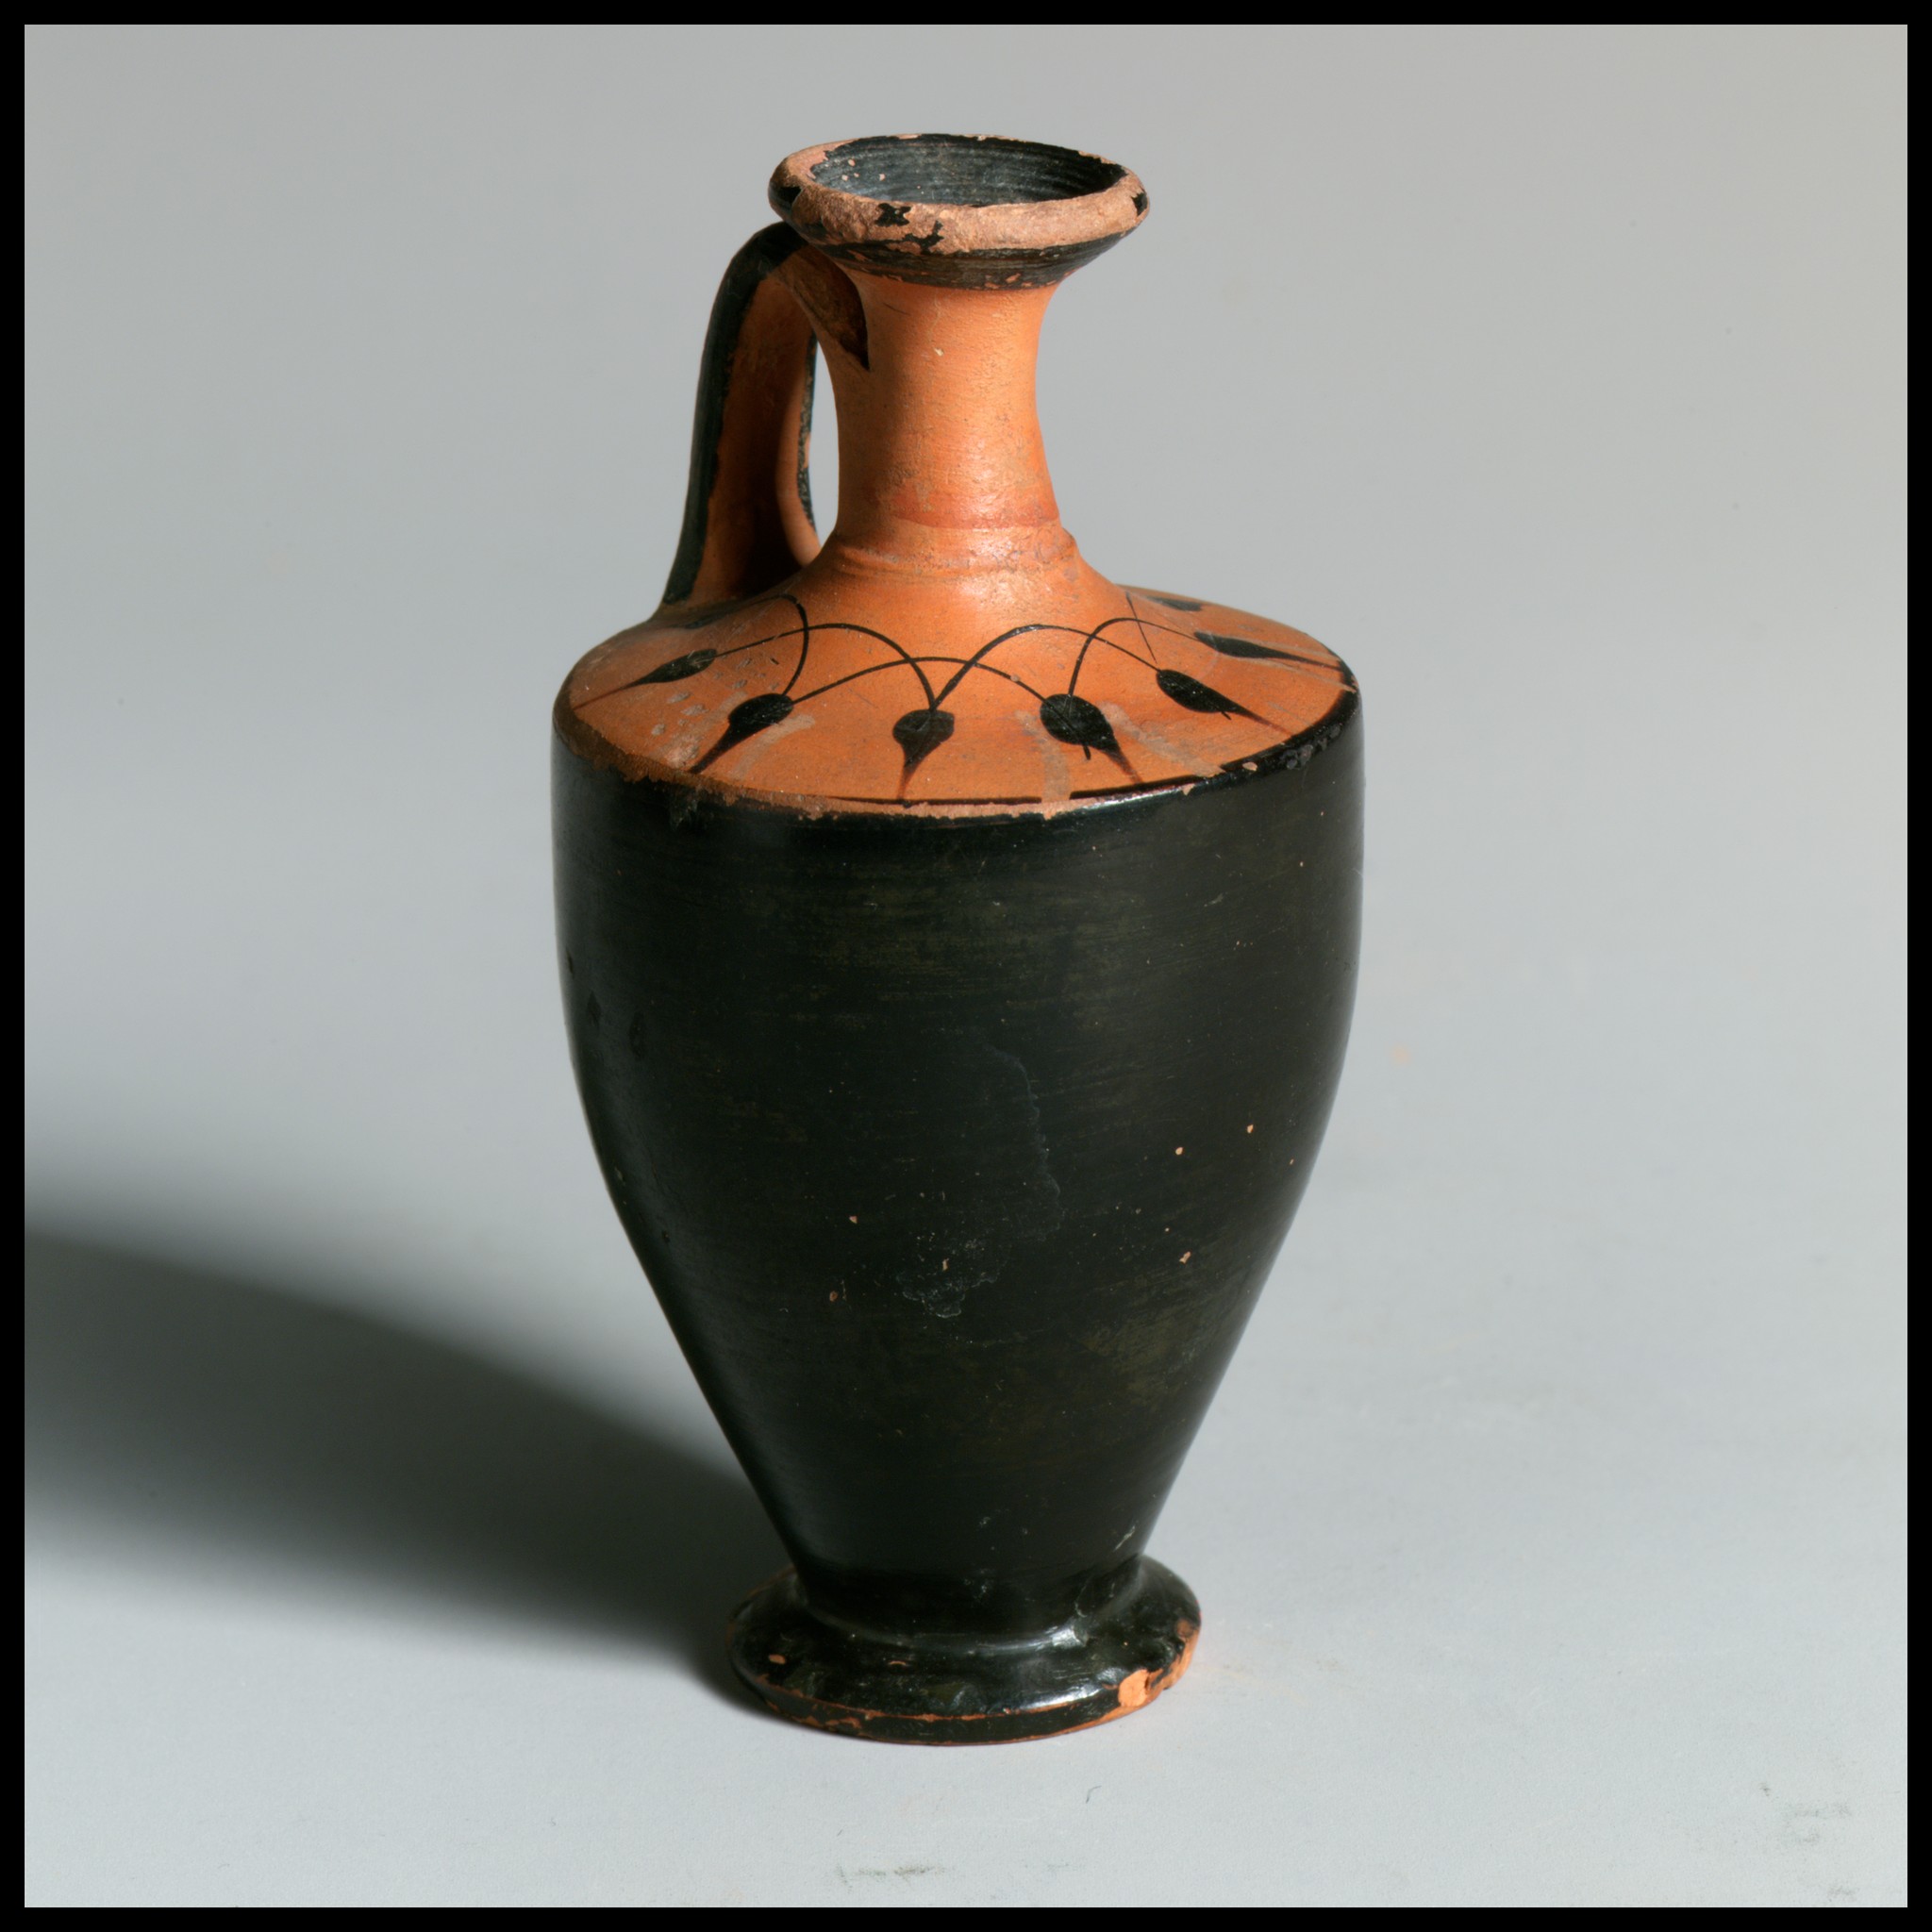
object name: lekythos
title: Terracotta lekythos (oil flask)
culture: greek, attic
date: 500 BCE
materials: terracotta